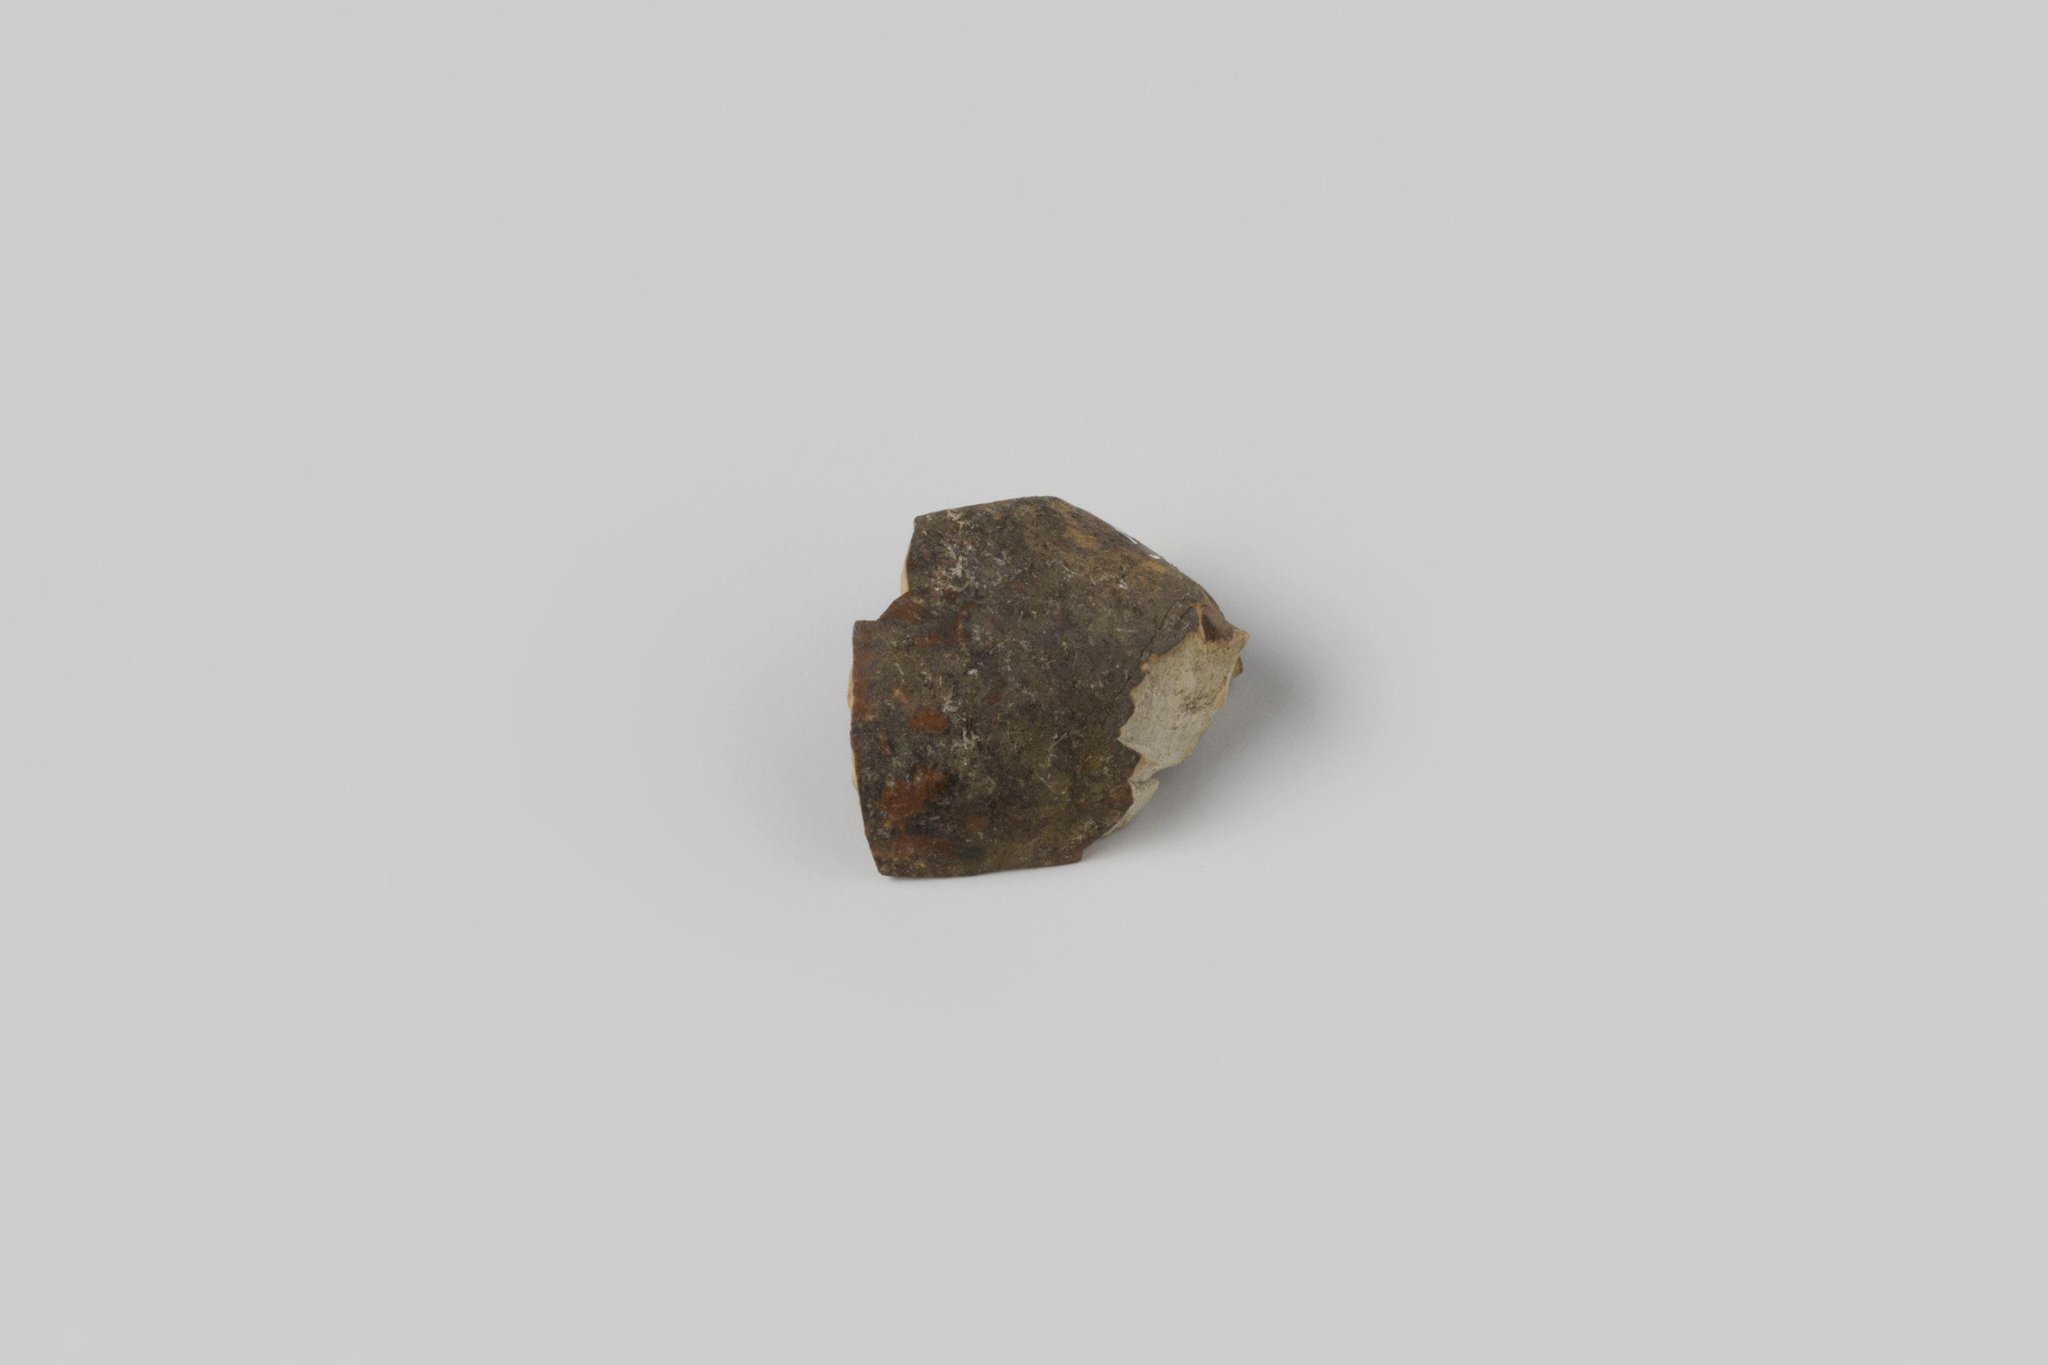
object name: pipe bowl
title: Fragment pijpenkop uit het wrak van de Oost-Indiëvaarder Hollandia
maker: Anonymous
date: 1700-1743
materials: clay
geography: netherlands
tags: verenigde oostindische compagnie, hollandia (schip), annet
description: Pipe, bowl, heelmark illegible; fragment.